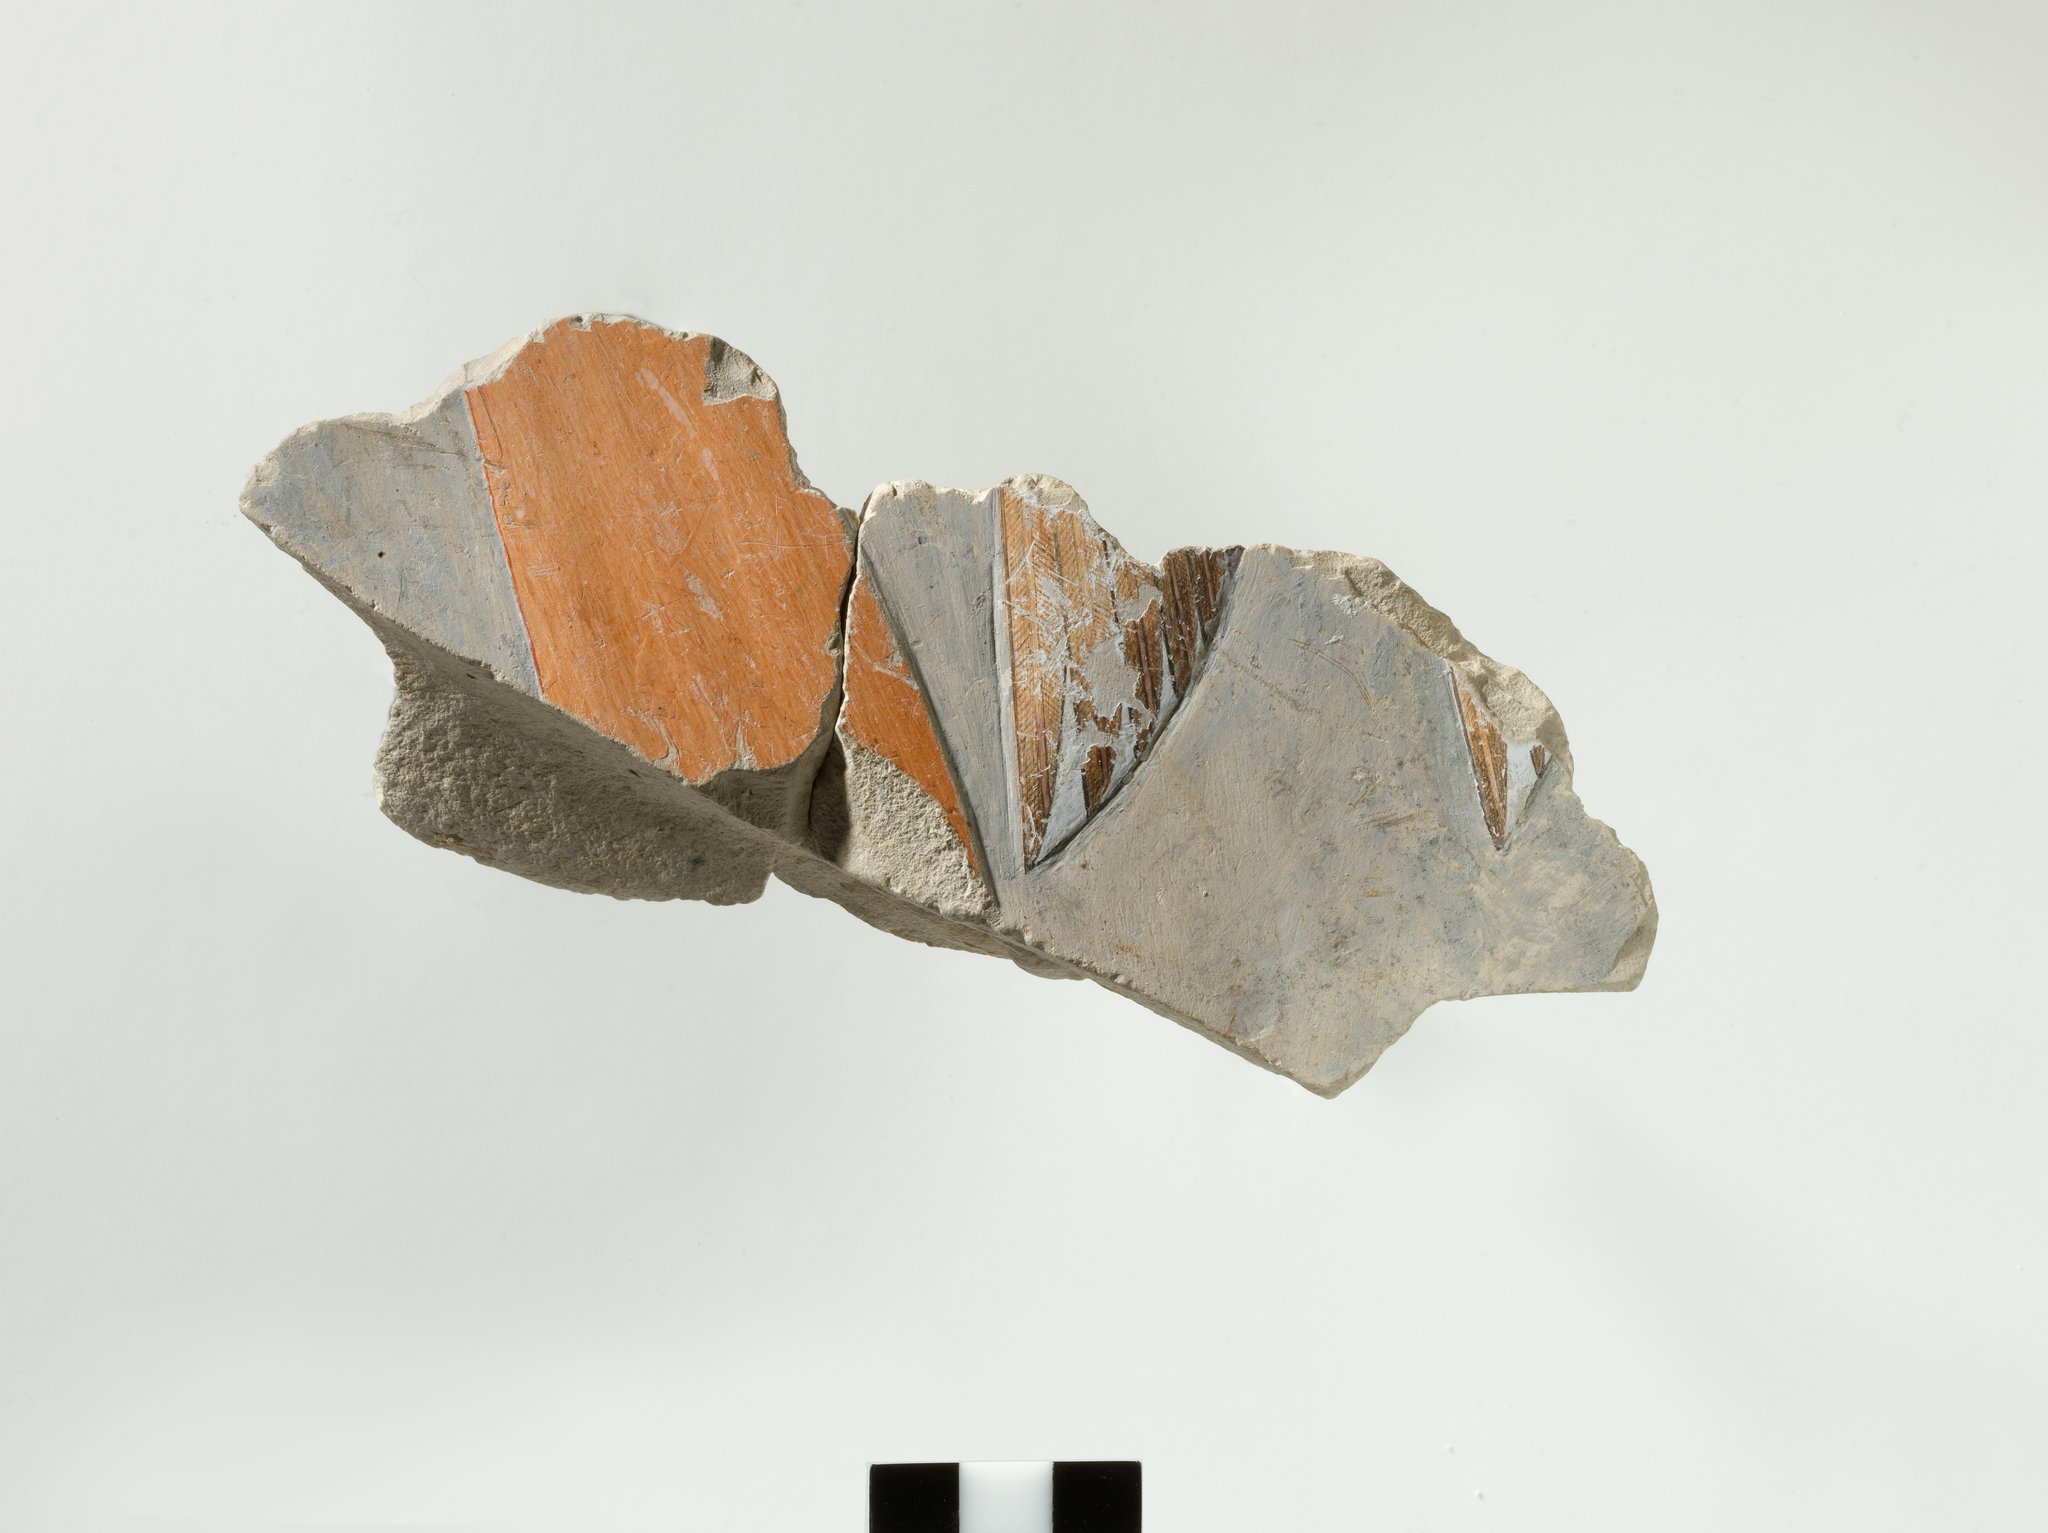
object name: relief fragment, tomb of meketre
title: Relief fragment from the tomb of Meketre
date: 1981-1975 BCE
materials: limestone, paint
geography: egypt